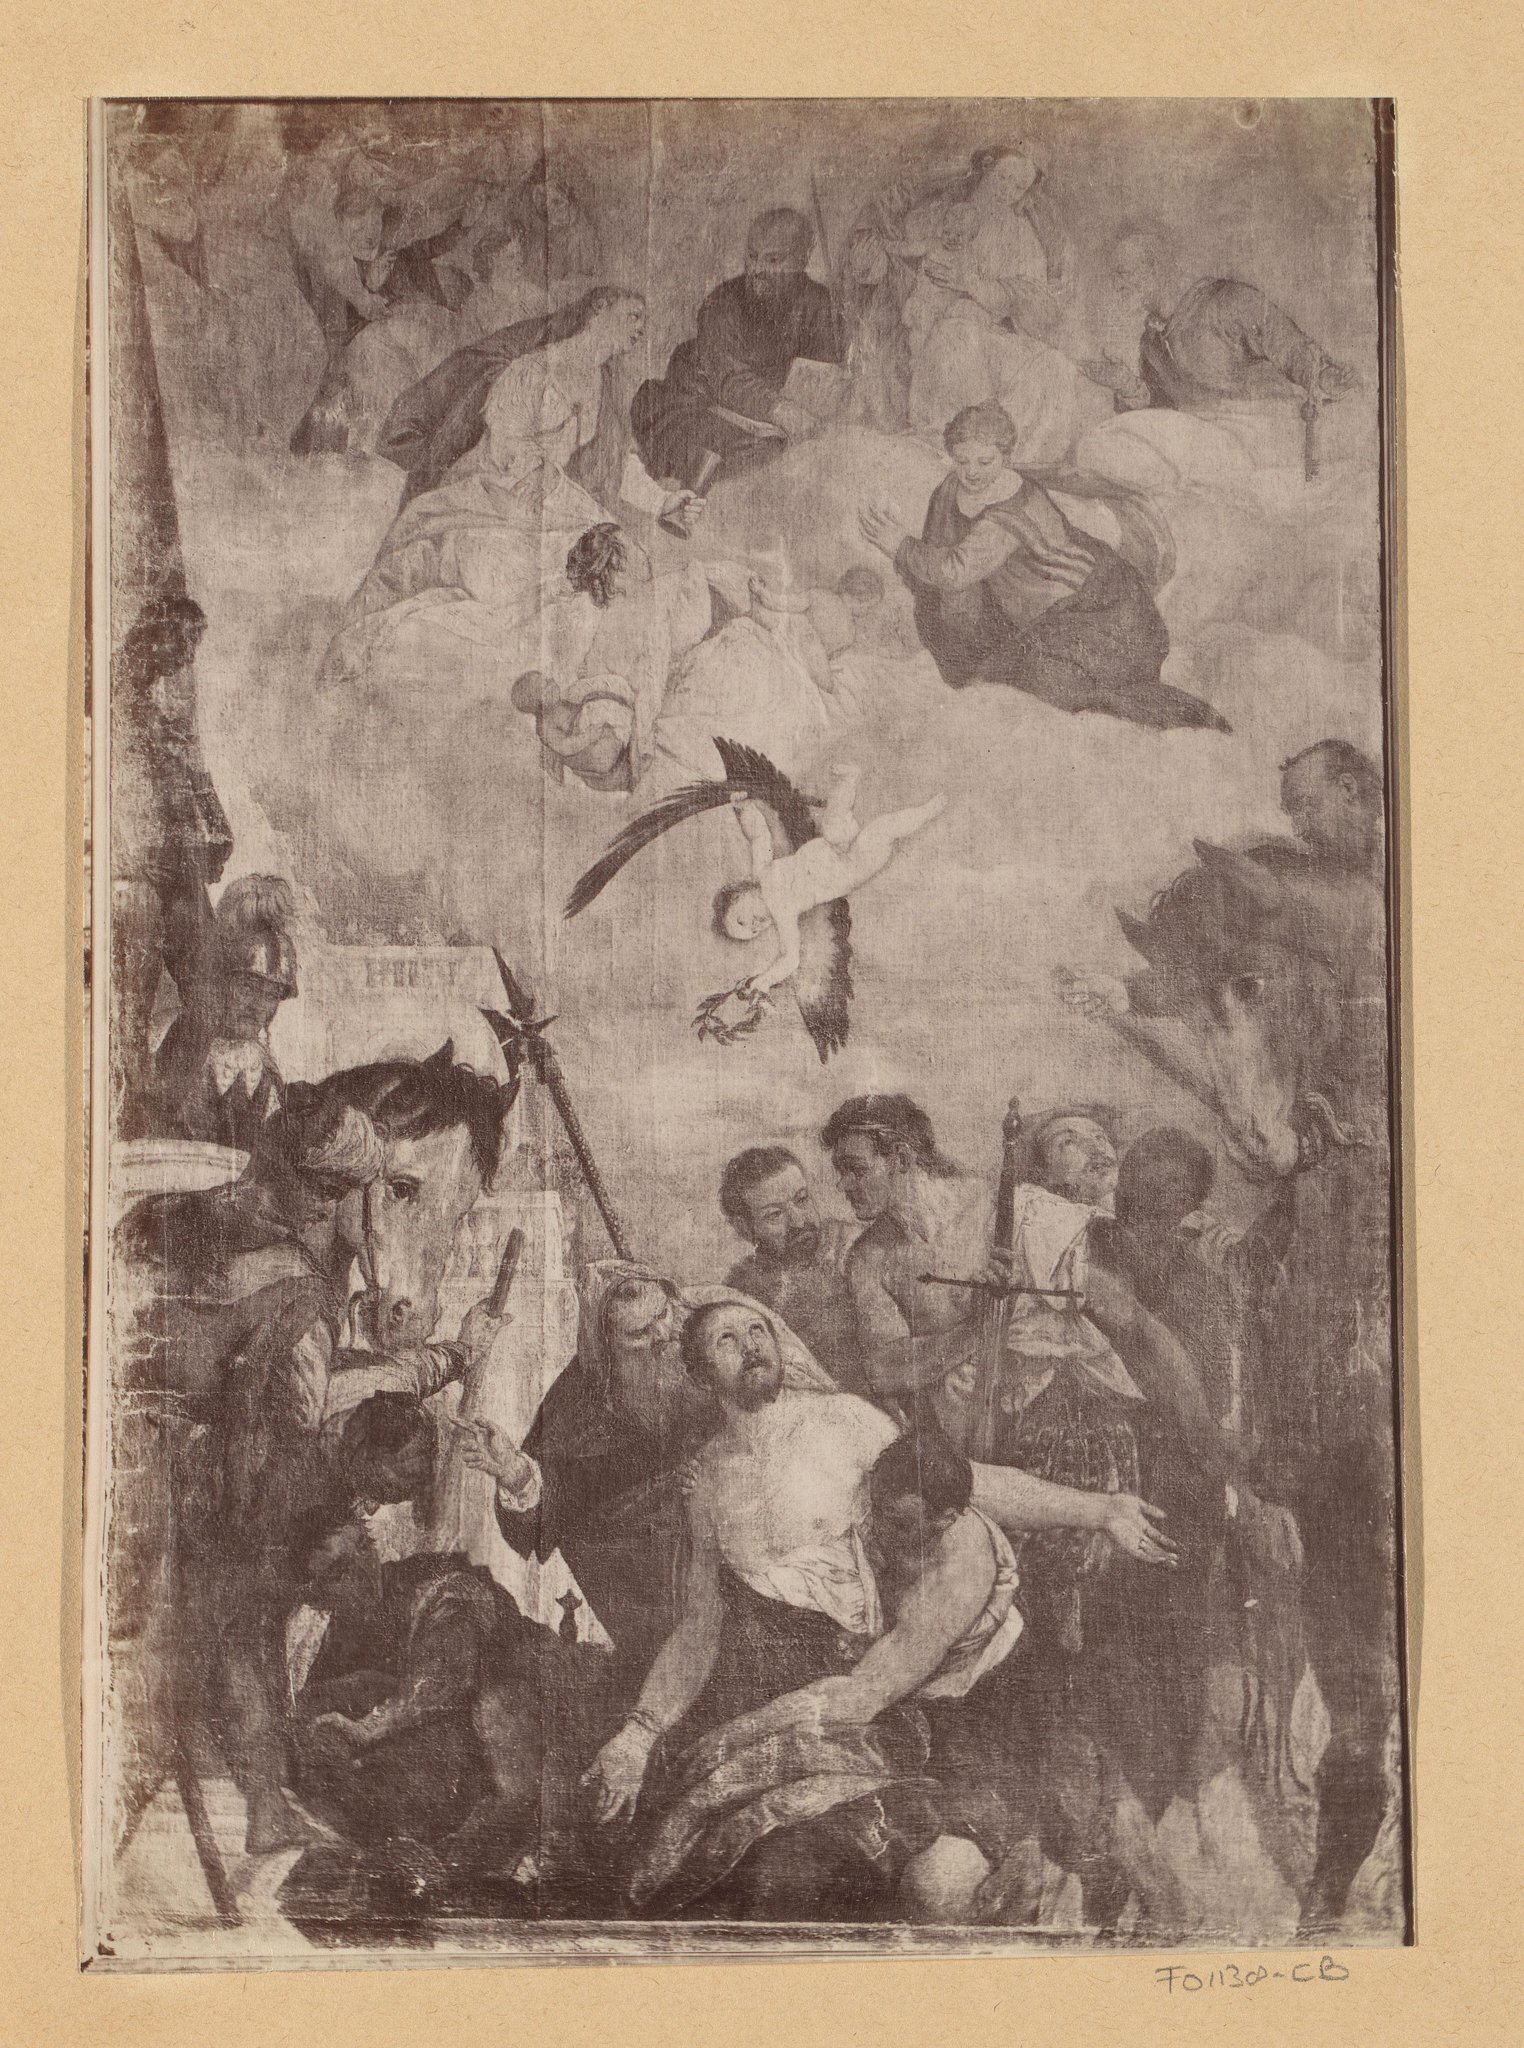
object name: reproduction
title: Fotoreproductie van (vermoedelijk) een schilderij, voorstellend de martelaarsdood van een onbekende heilige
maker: Anonymous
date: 1860-1900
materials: photographic support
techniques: albumen print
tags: death penalty, execution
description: Onderdeel van Reisalbum met opnames van kunstwerken en bezienswaardigheden in Italië, Griekenland en Frankrijk.